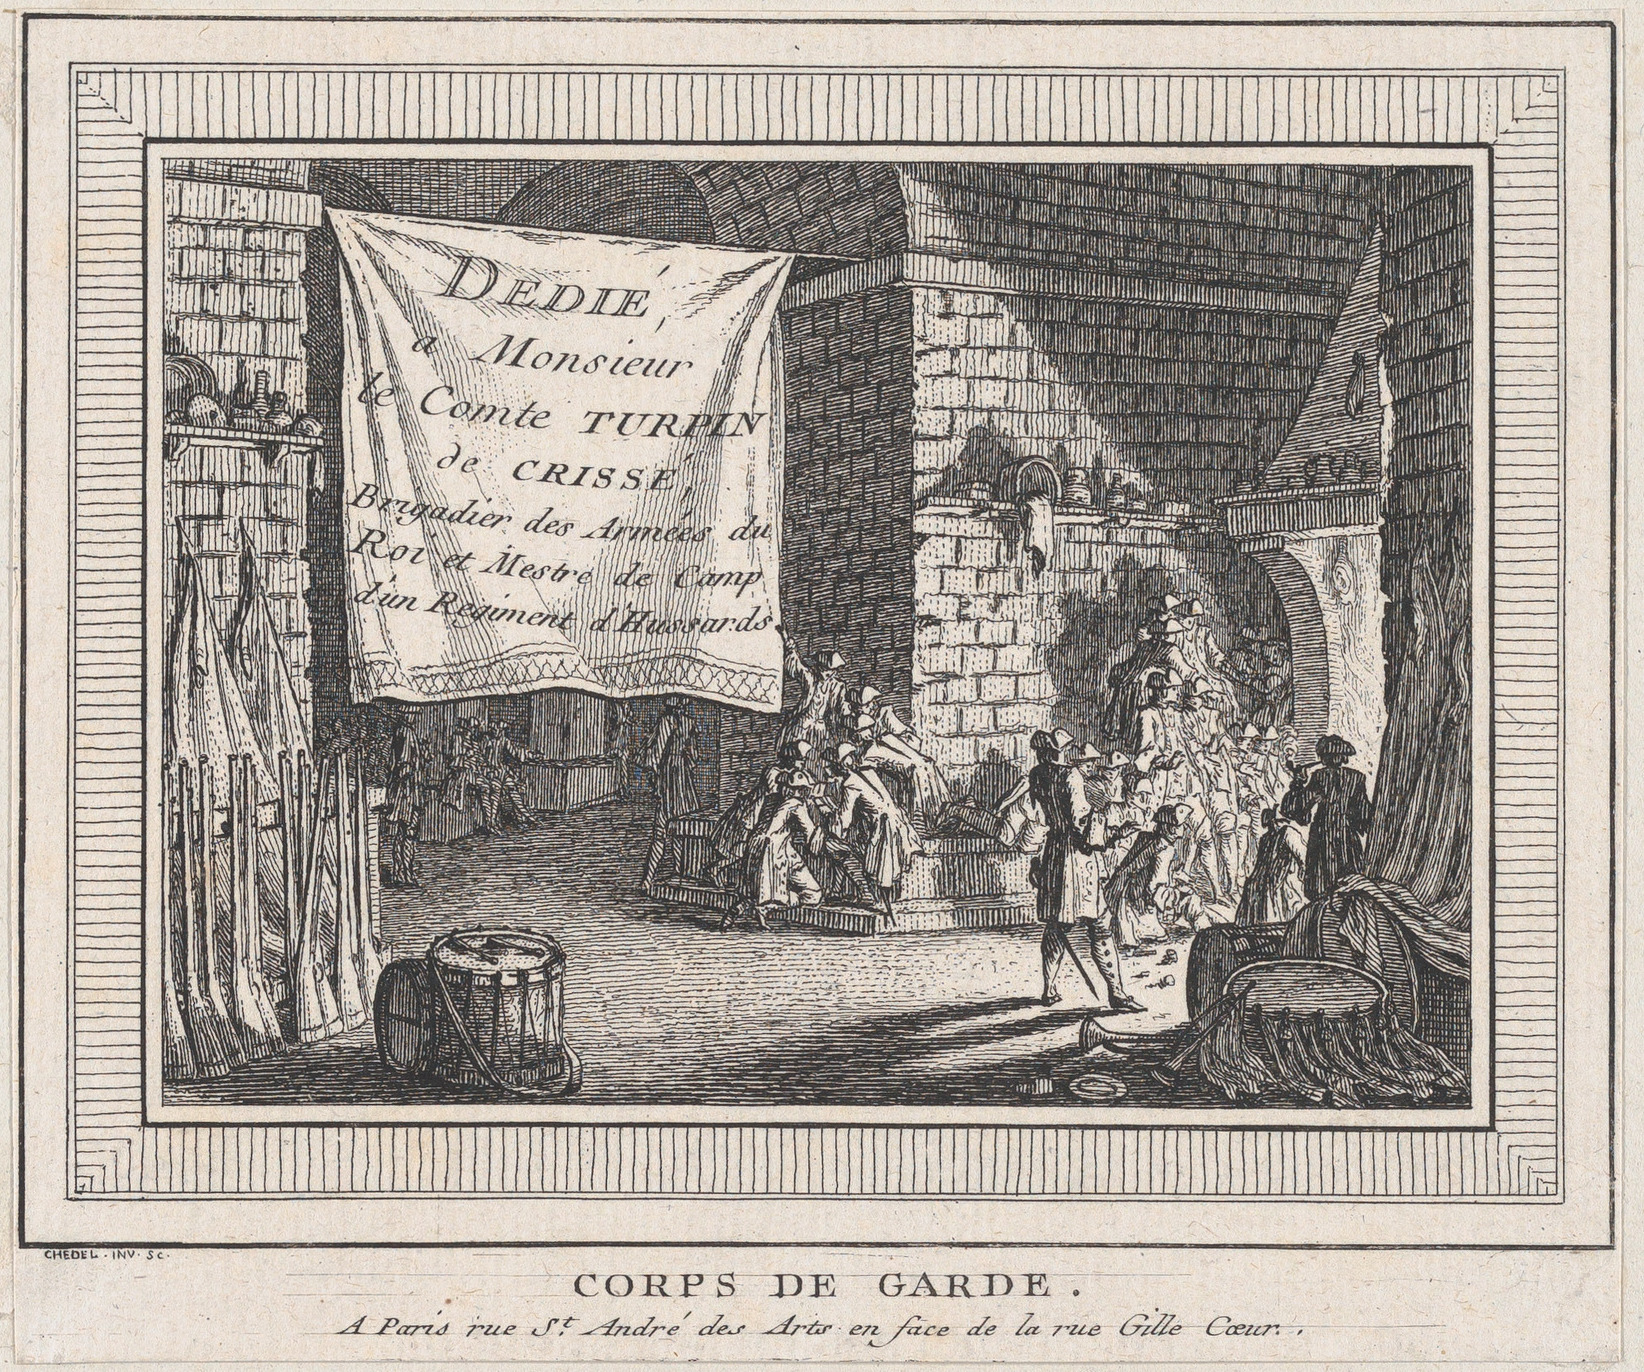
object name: print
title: Bataille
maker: quentin pierre chedel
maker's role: artist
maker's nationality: french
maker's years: 1705-1763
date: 1701-1800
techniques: etching